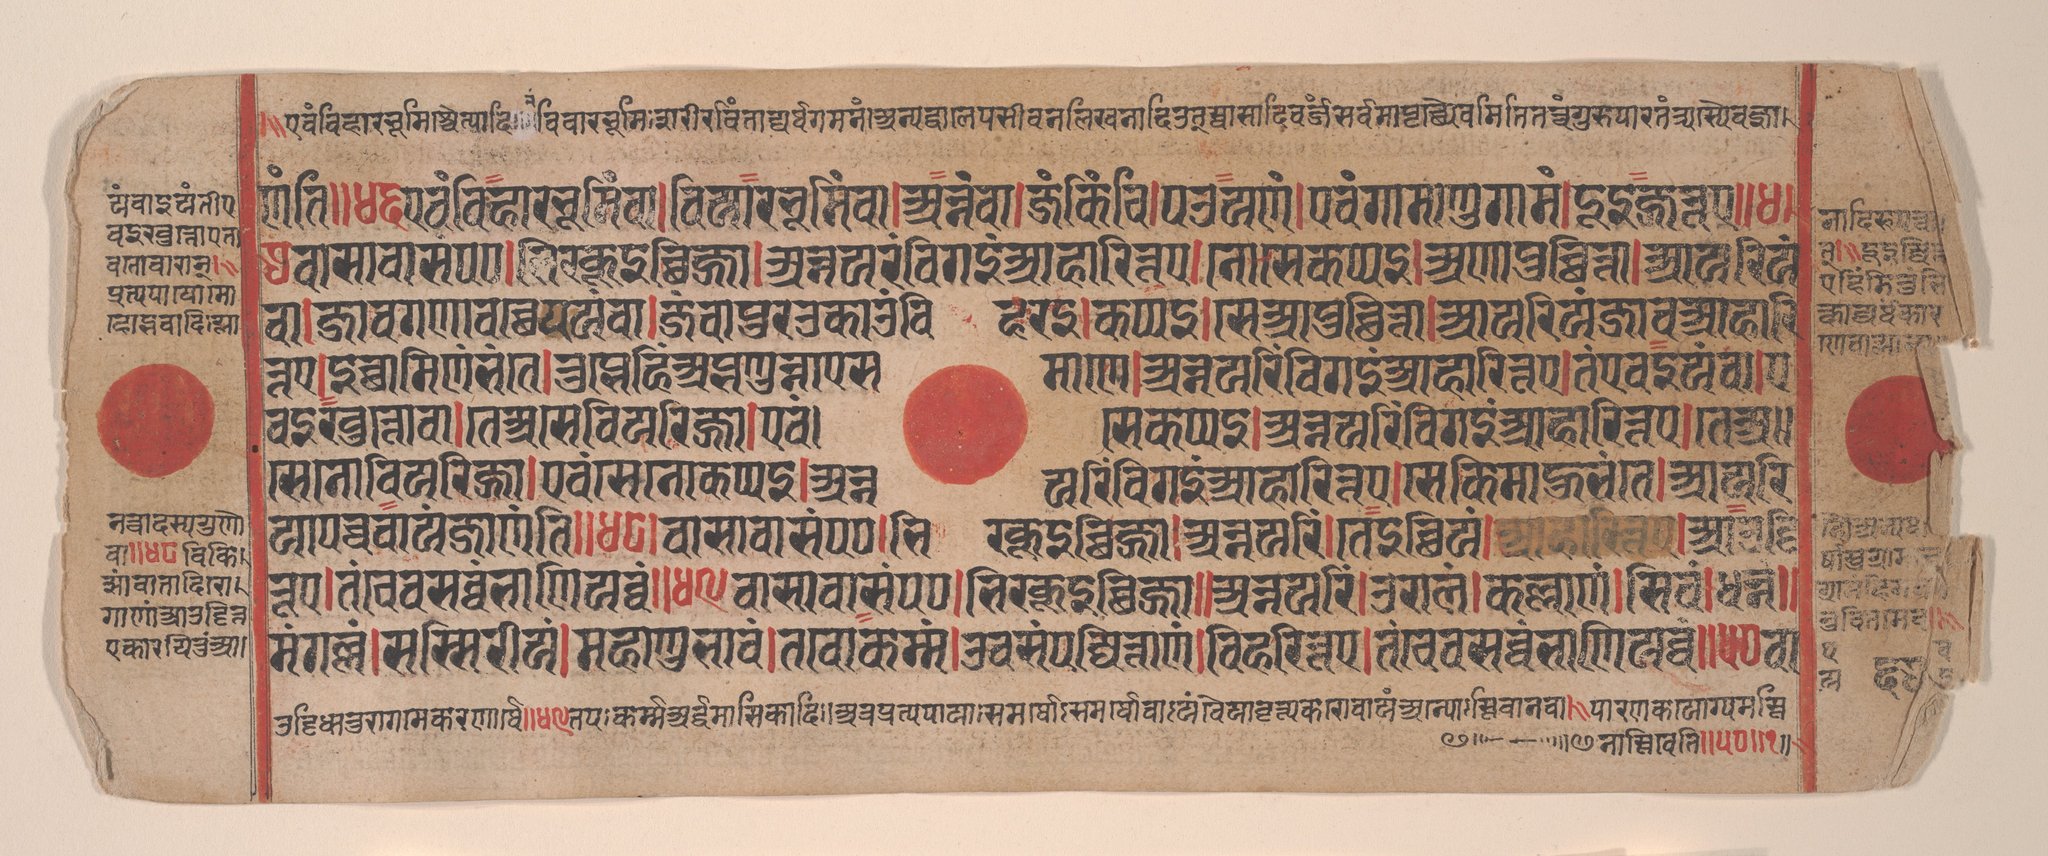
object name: folio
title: Leaf from a Kalpa Sutra (Jain Book of Rituals)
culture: indian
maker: bhadrabahu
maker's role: artist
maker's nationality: indian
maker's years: 356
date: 1401-1500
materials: gold, ink, paper, watercolor